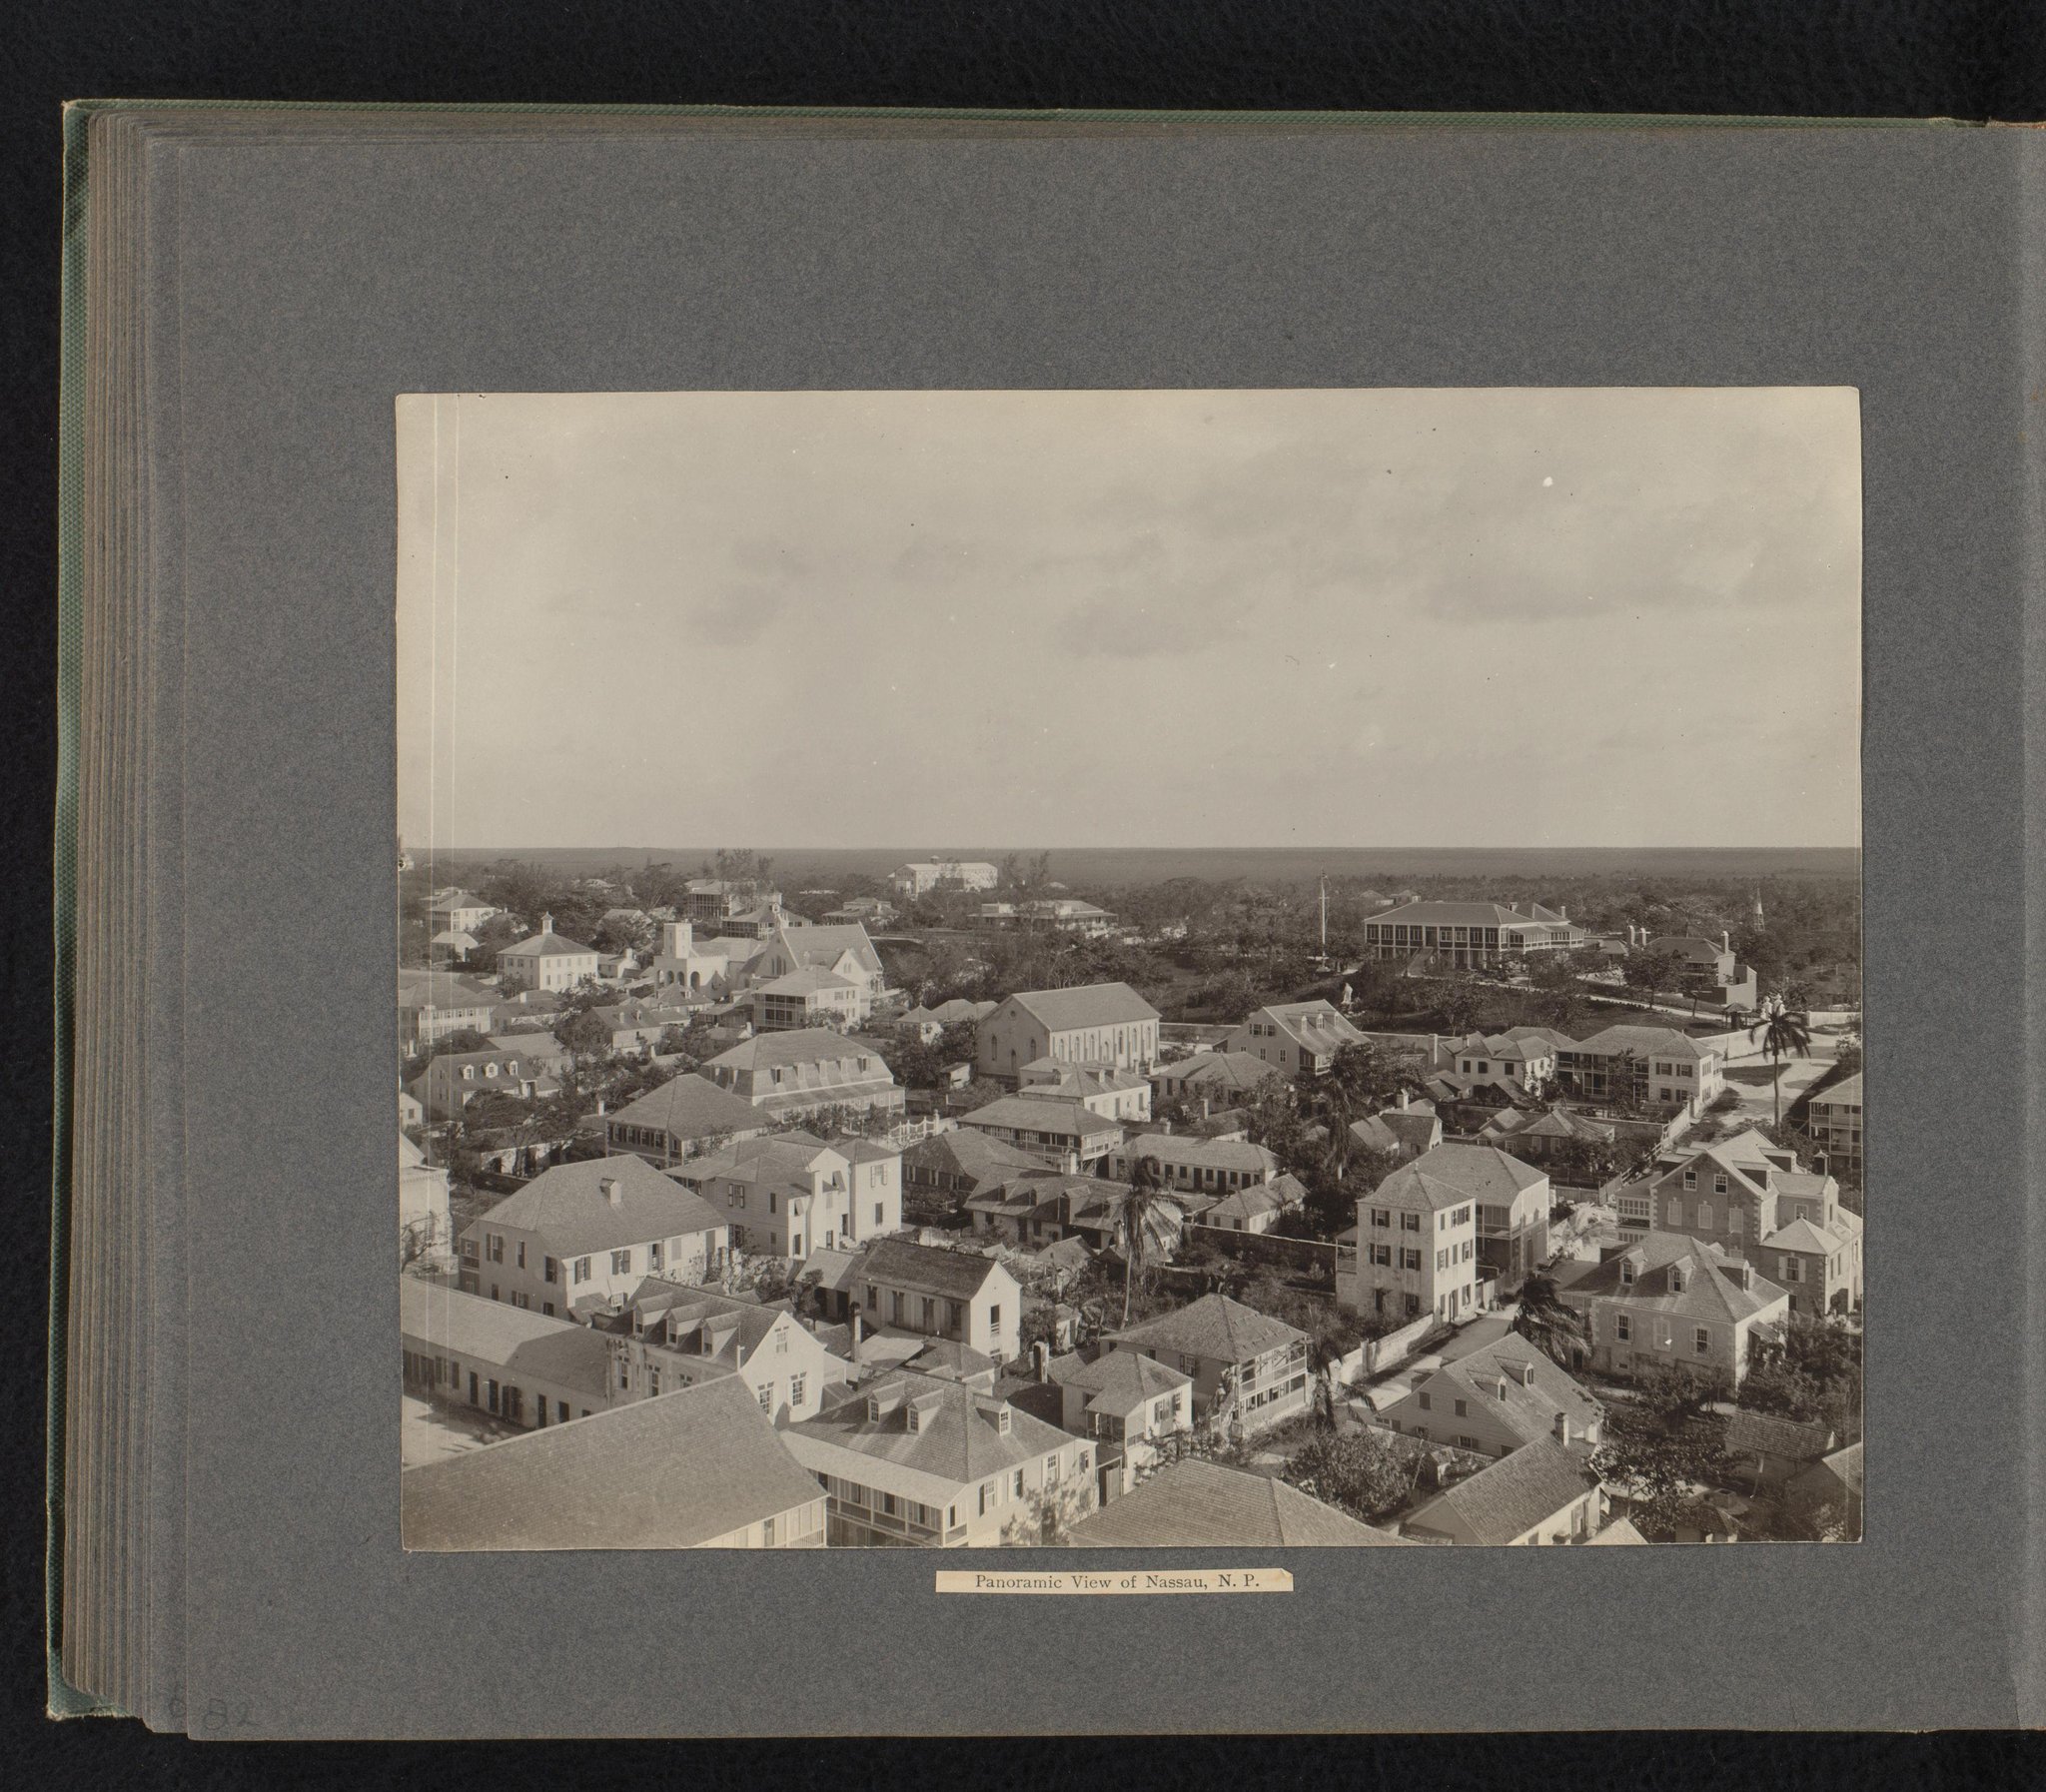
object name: photograph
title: Panoramic View of Nassau, N.P.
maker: jacob frank coonley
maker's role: fotograaf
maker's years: 1832-1915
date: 1889-1895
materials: paper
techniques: platinum process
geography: nassau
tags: city-view in general; 'veduta'